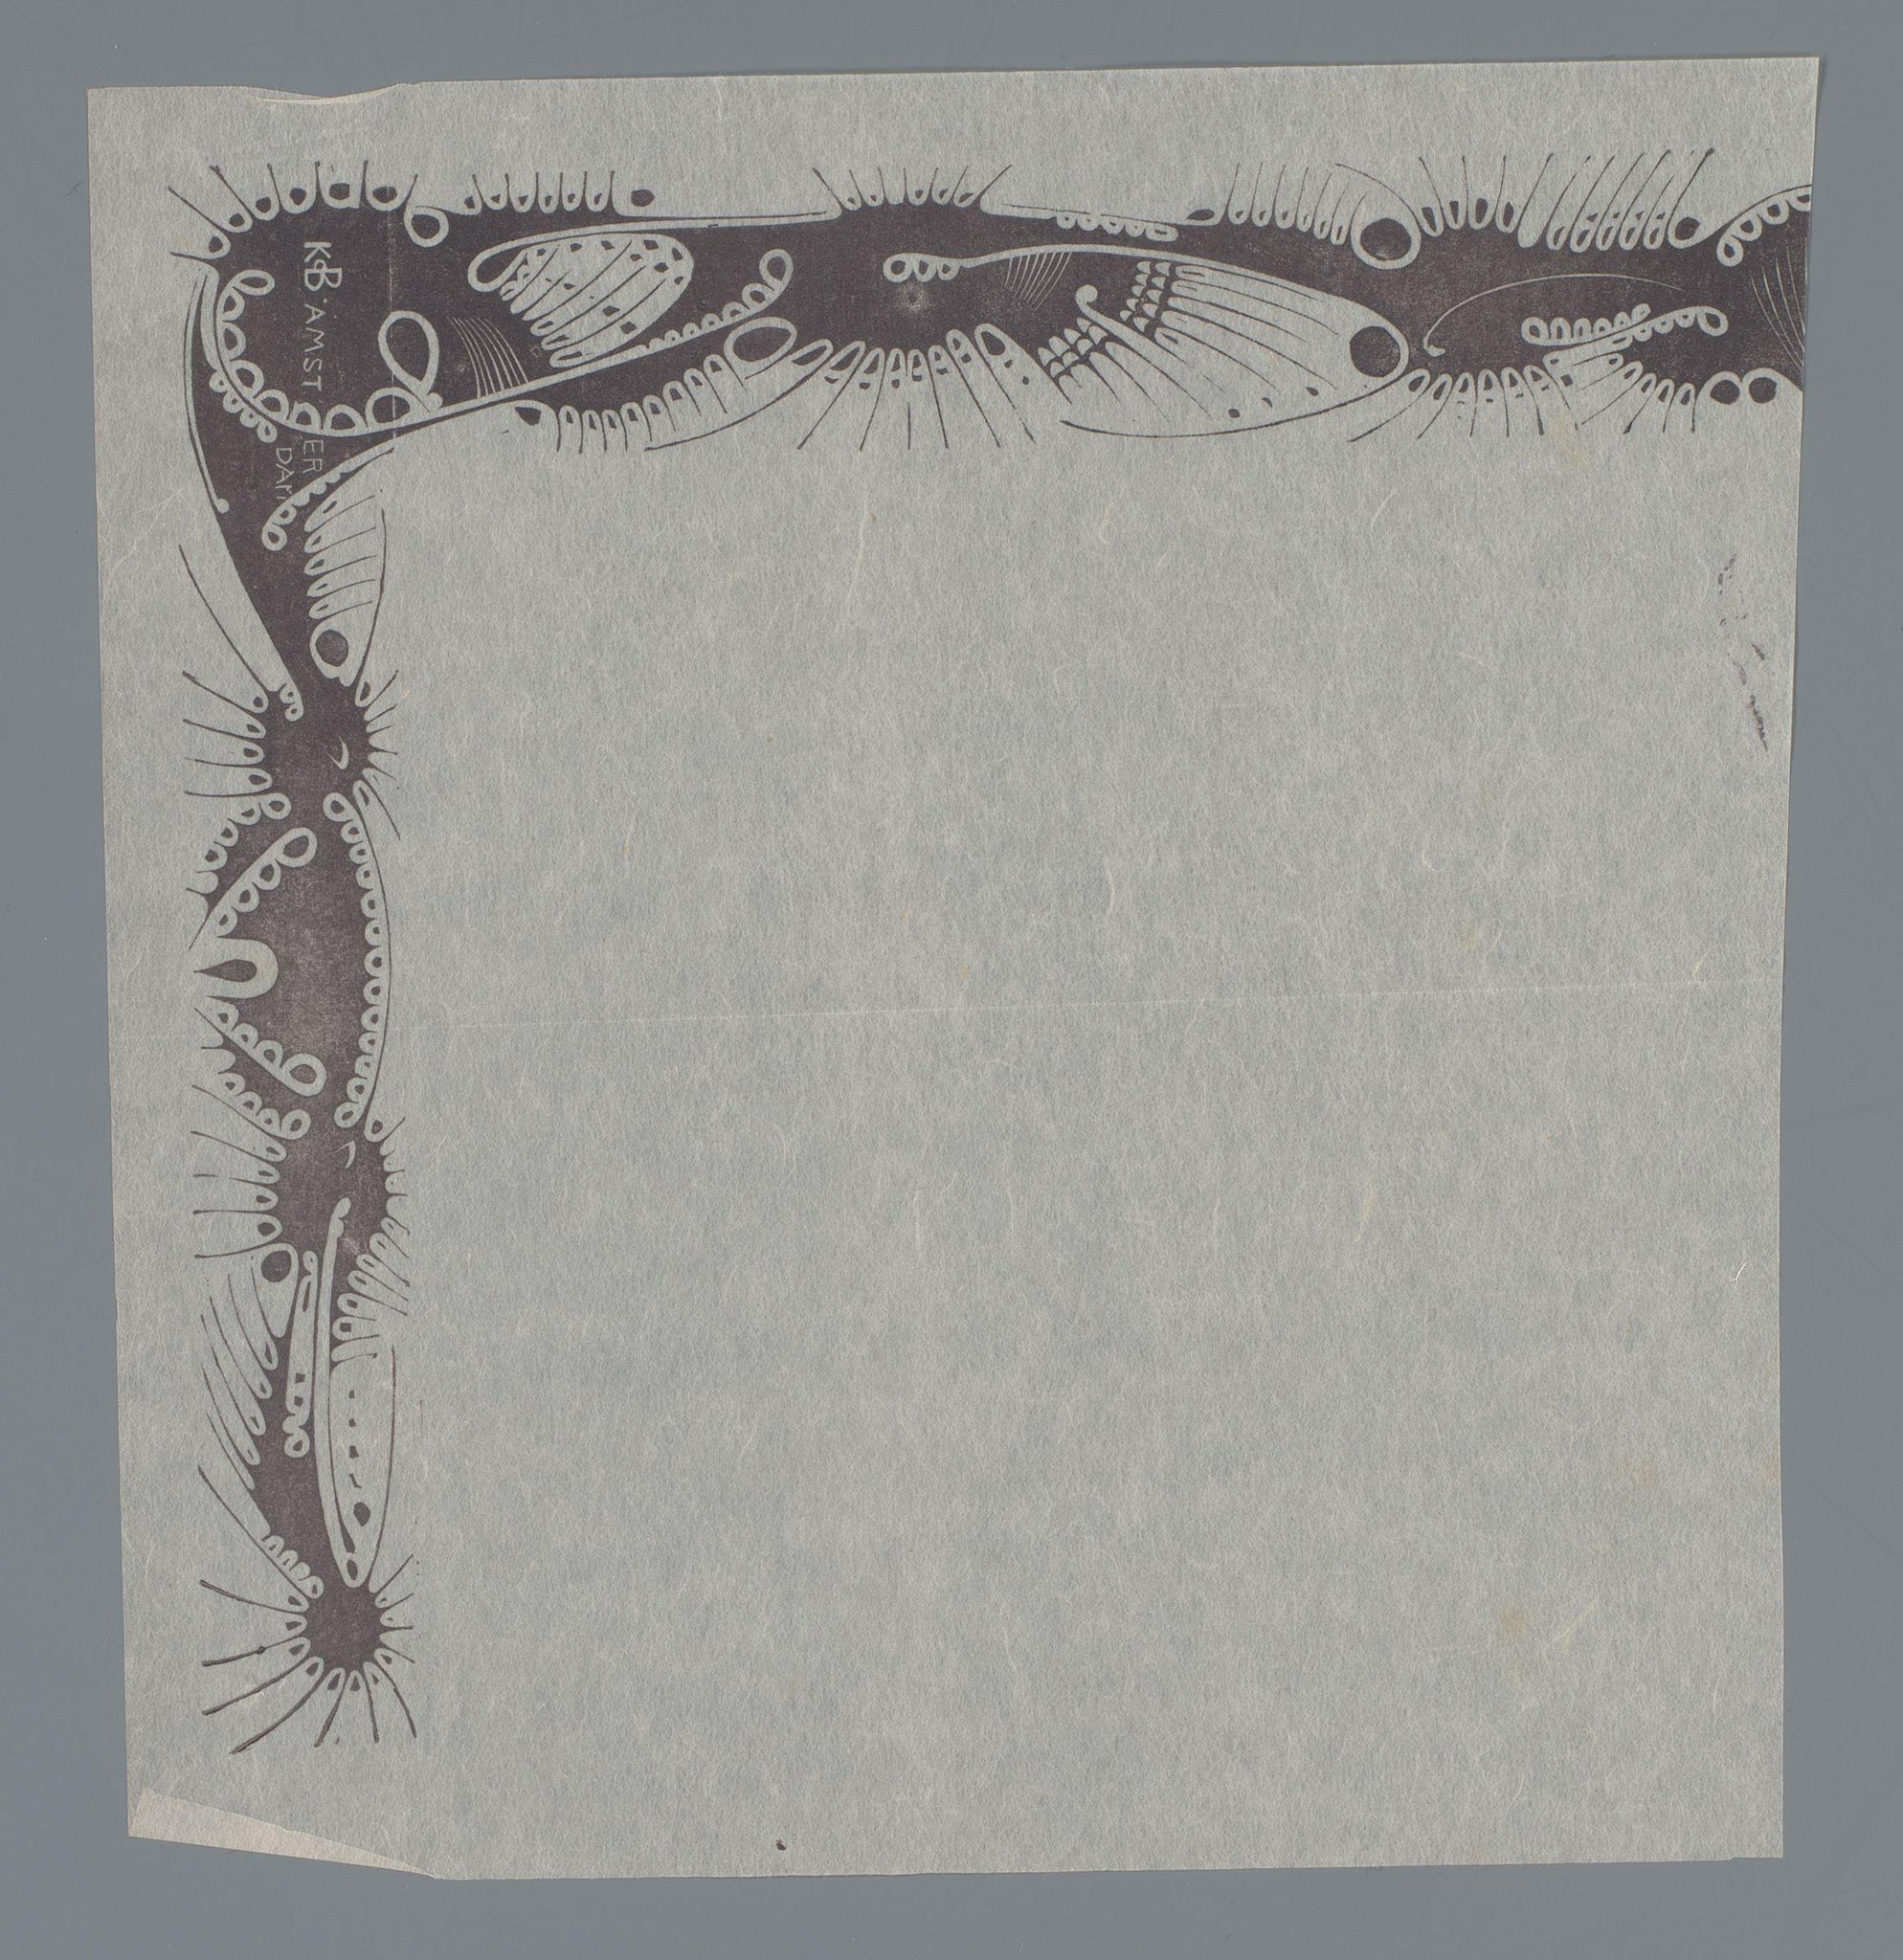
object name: print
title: Randdecoratie en staart van het prospectus van het Tijdschrift voor vercieringskunst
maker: karel petrus cornelis de bazel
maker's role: draughtsman, print maker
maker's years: 1869-1923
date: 1896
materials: paper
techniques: woodcut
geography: amsterdam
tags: title-page, ornament derived from plant forms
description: Fragment van: Prospectus tijdschrift voor vercieringskunst. Haarlem: H. Kleinmann & Co., 1896.